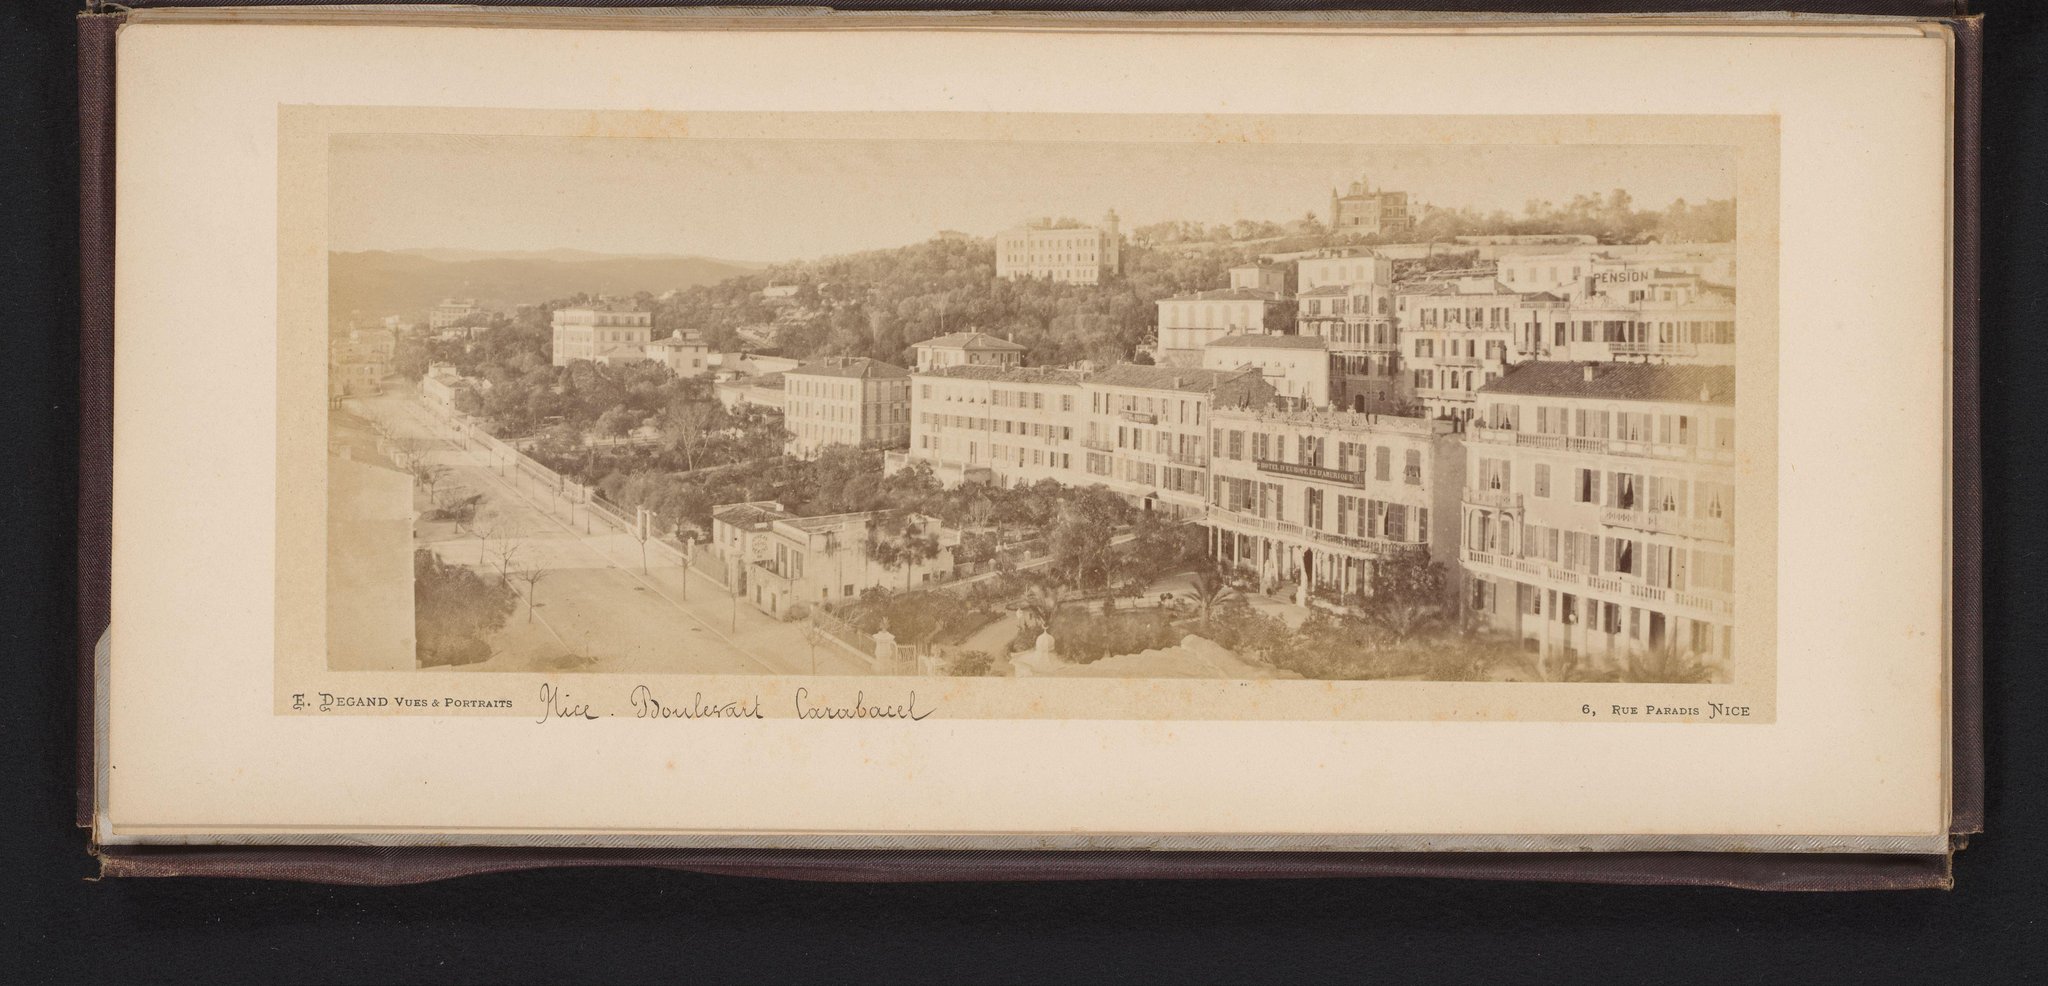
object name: blad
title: Gezicht op boulevard Carabacel te Nice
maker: eugène degand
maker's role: painter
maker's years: 1829-1911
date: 1872-1874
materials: cardboard, photographic support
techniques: albumen print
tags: avenue, boulevard, promenade, esplanade, civic architecture; edifices; dwellings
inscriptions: inscription: ‘E. Degand Vues&Portraits 6, Rue Paradis Nice’, annotation: ‘Nice, Boulevard Carabacel’